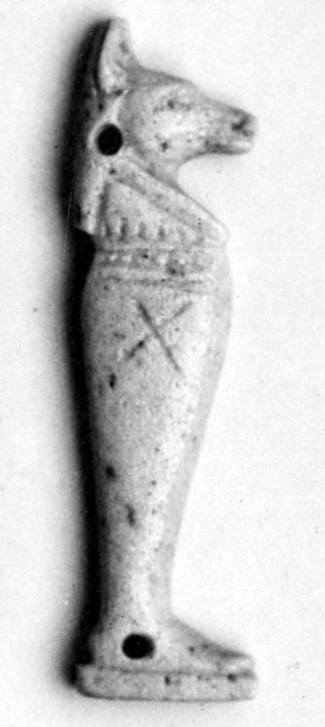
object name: amulet, duamutef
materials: faience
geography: egypt